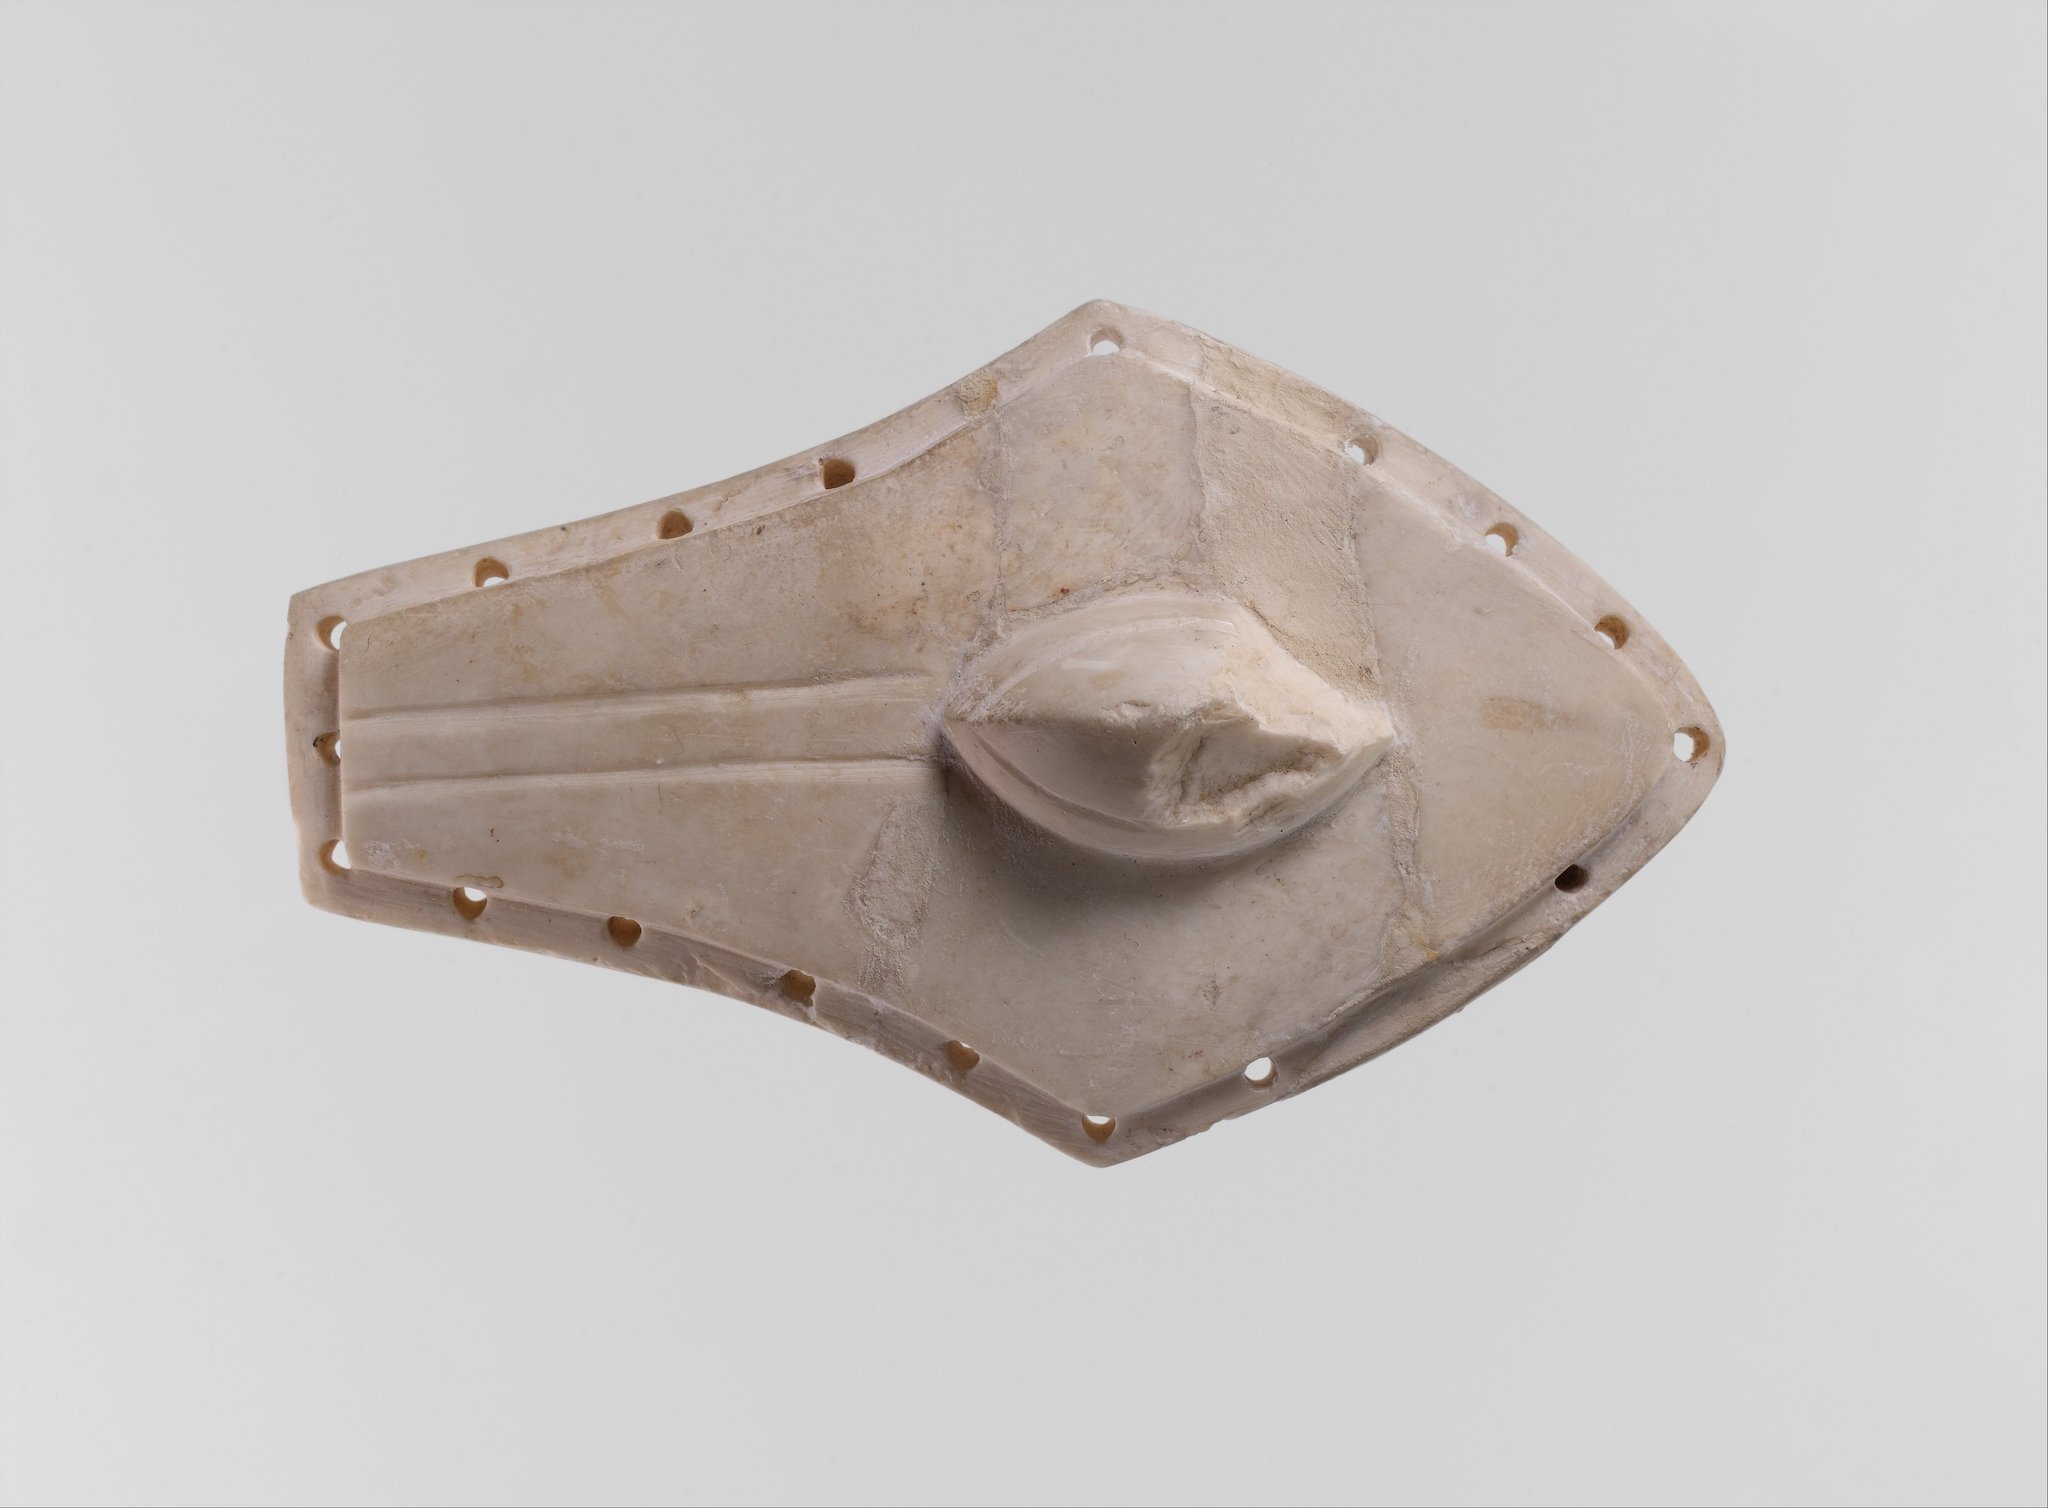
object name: horse blinker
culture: assyrian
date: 900-701 BCE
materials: stone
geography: mesopotamia